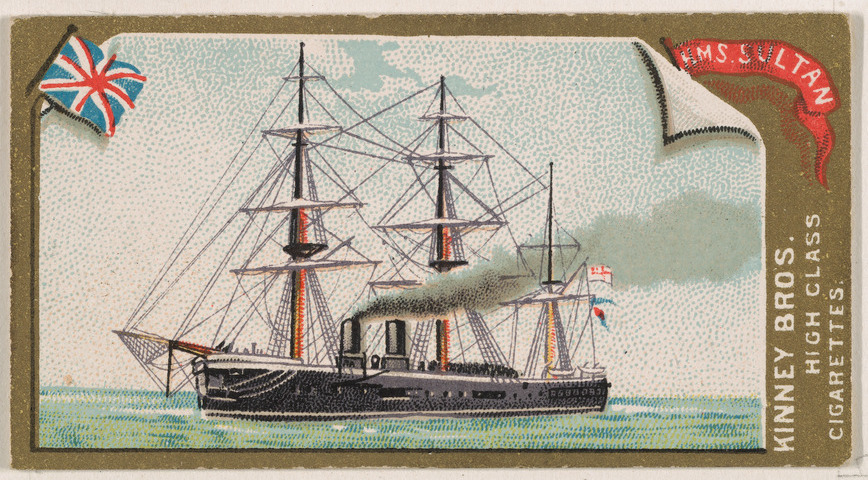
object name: print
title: H.M.S. Sultan, from the Naval Vessels of the World series (N226) issued by Kinney Bros.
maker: kinney brothers tobacco company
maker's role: publisher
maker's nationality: american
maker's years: 1869-2011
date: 1889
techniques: color lithograph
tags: navy,ships